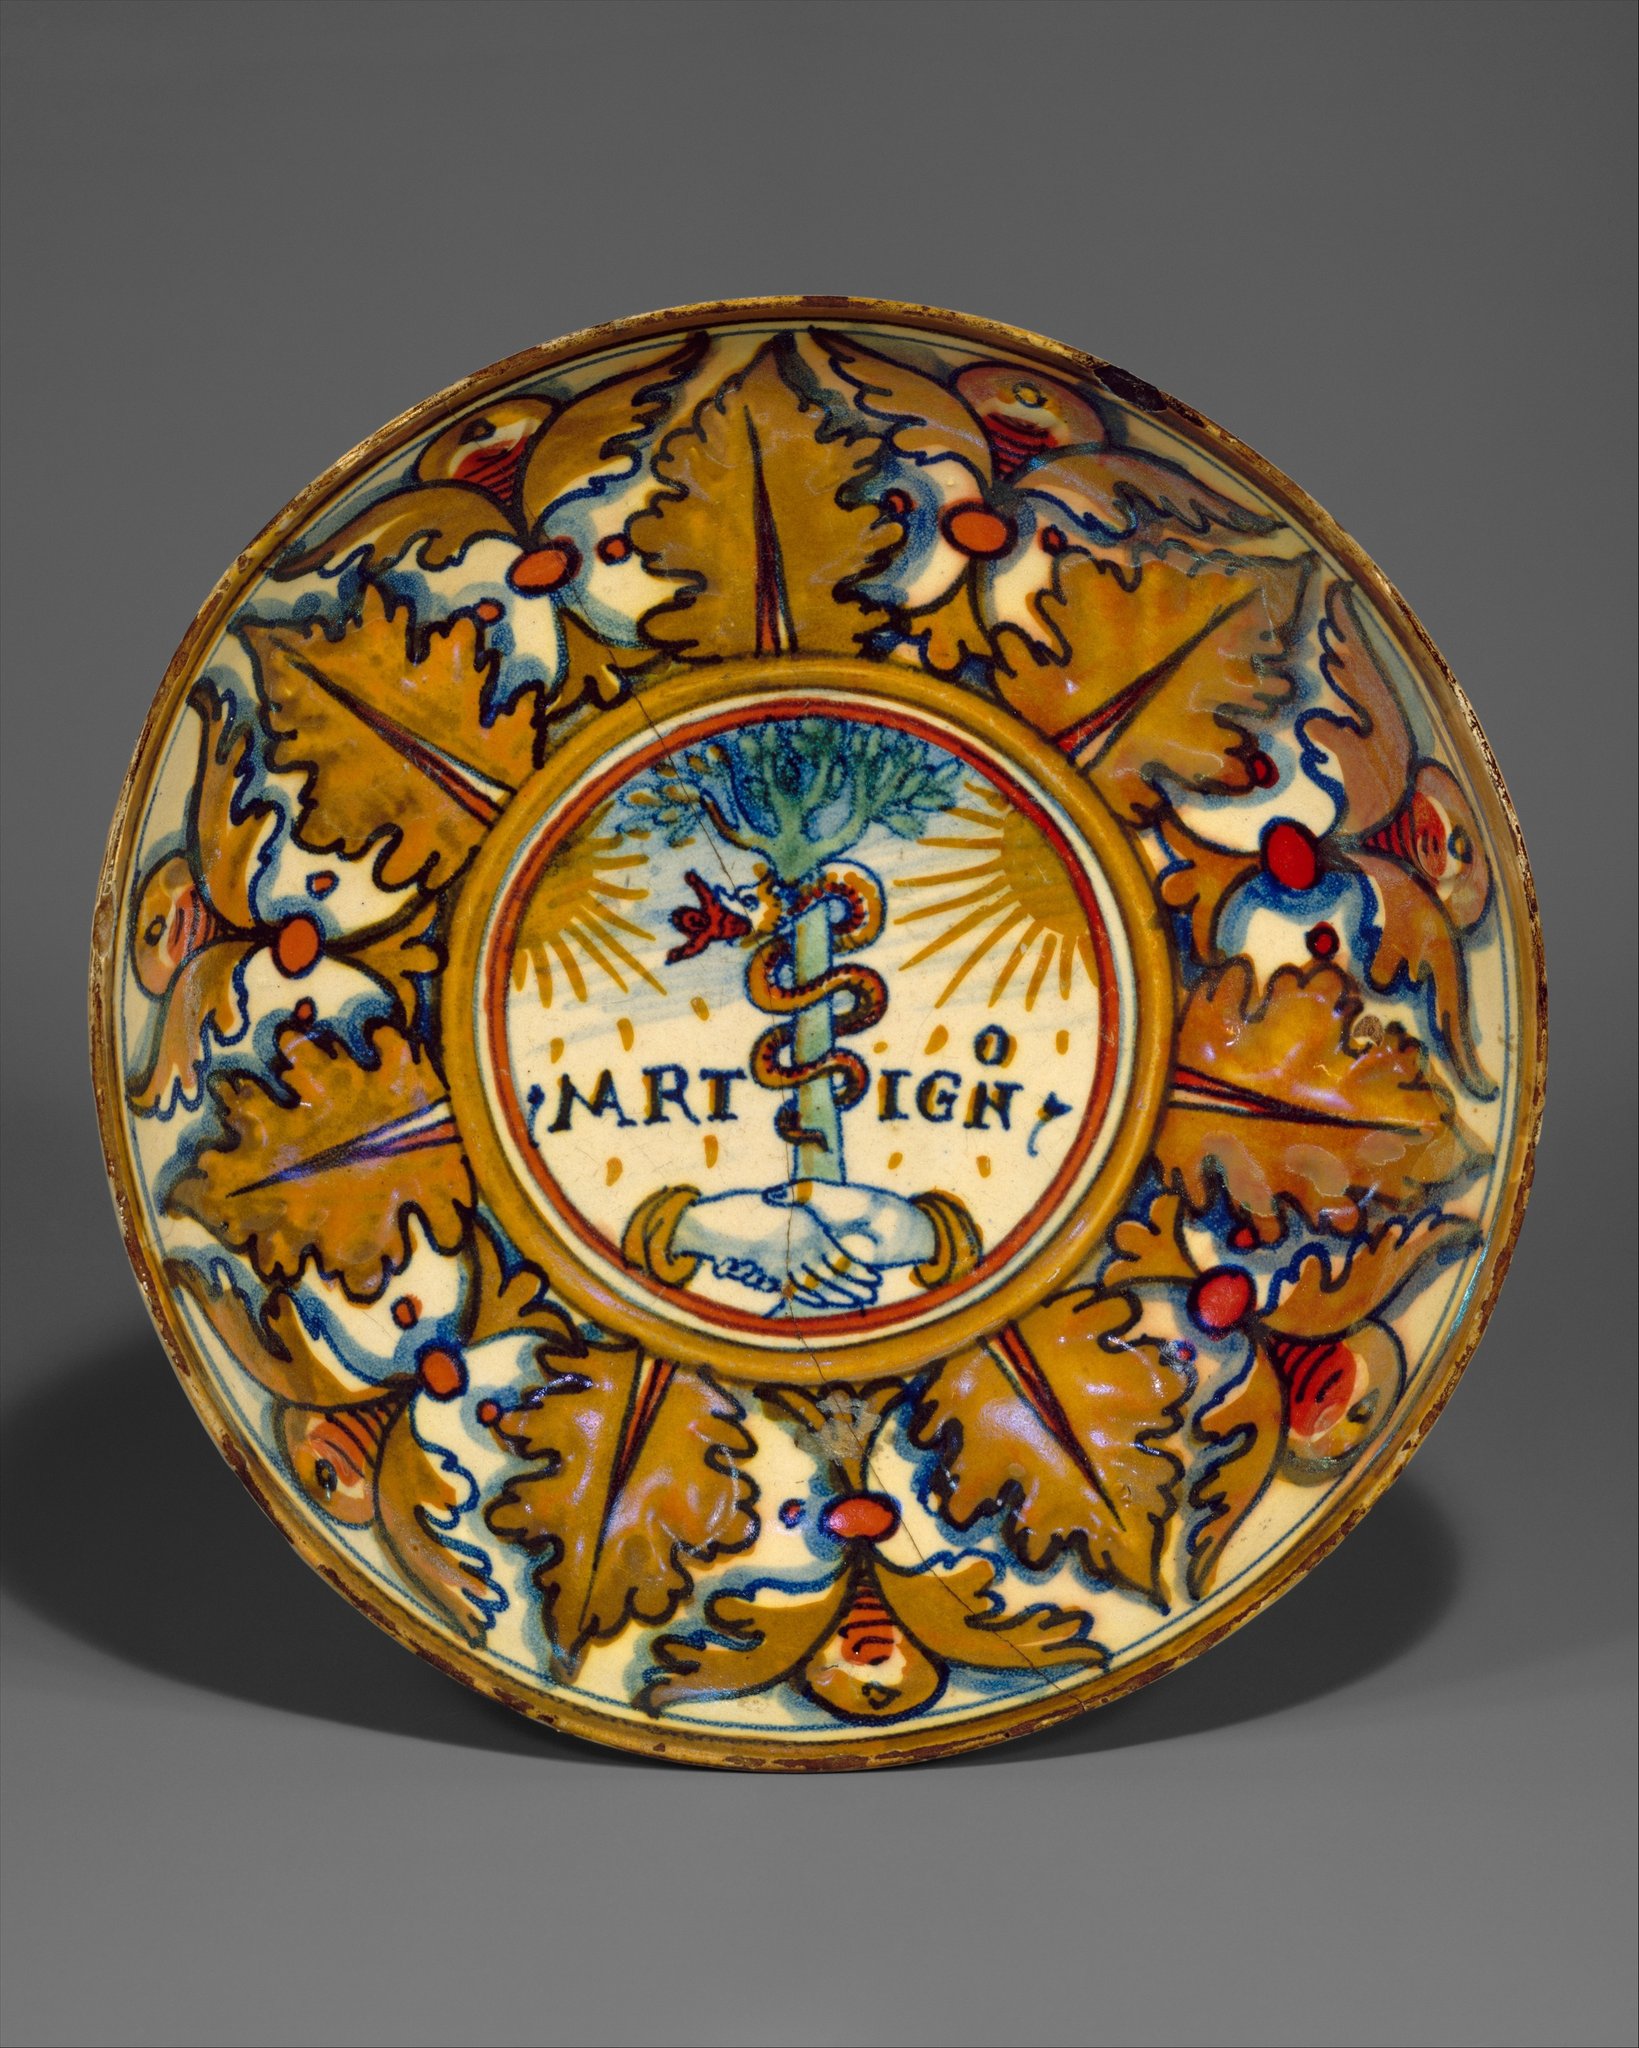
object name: dish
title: Dish (coppa)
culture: italian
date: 1530-1535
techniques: maiolica, glazing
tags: hands,serpents